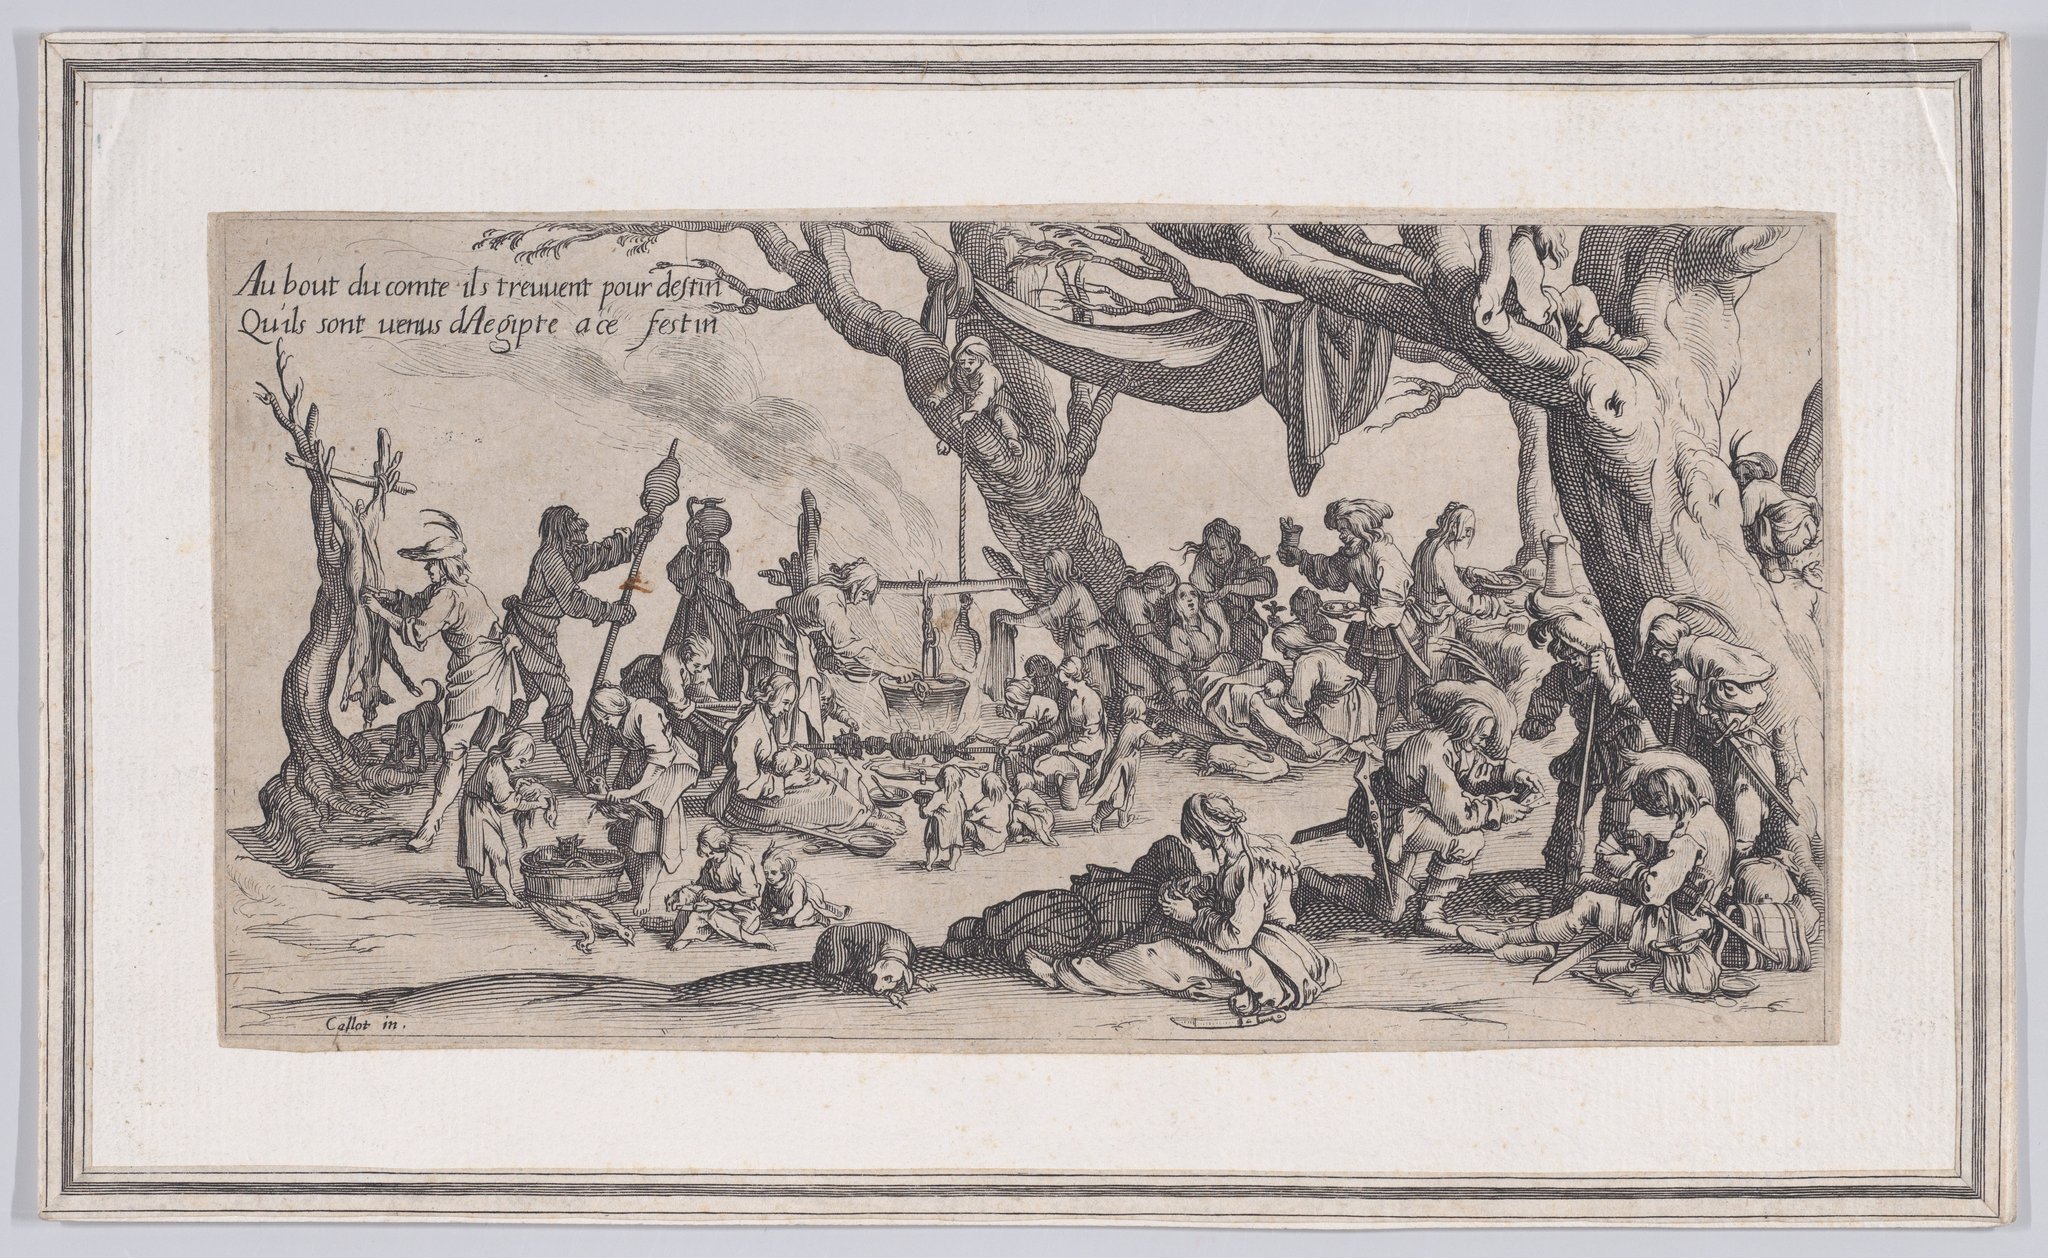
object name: print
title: Copy of Le Halte des Bohémiens: Les Apprêts du Festin (The Gypsy Stopover: The Preparations for the Feast), from "Le Bohémiens..."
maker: Anonymous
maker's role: artist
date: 1601-1700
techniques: engraving, etching